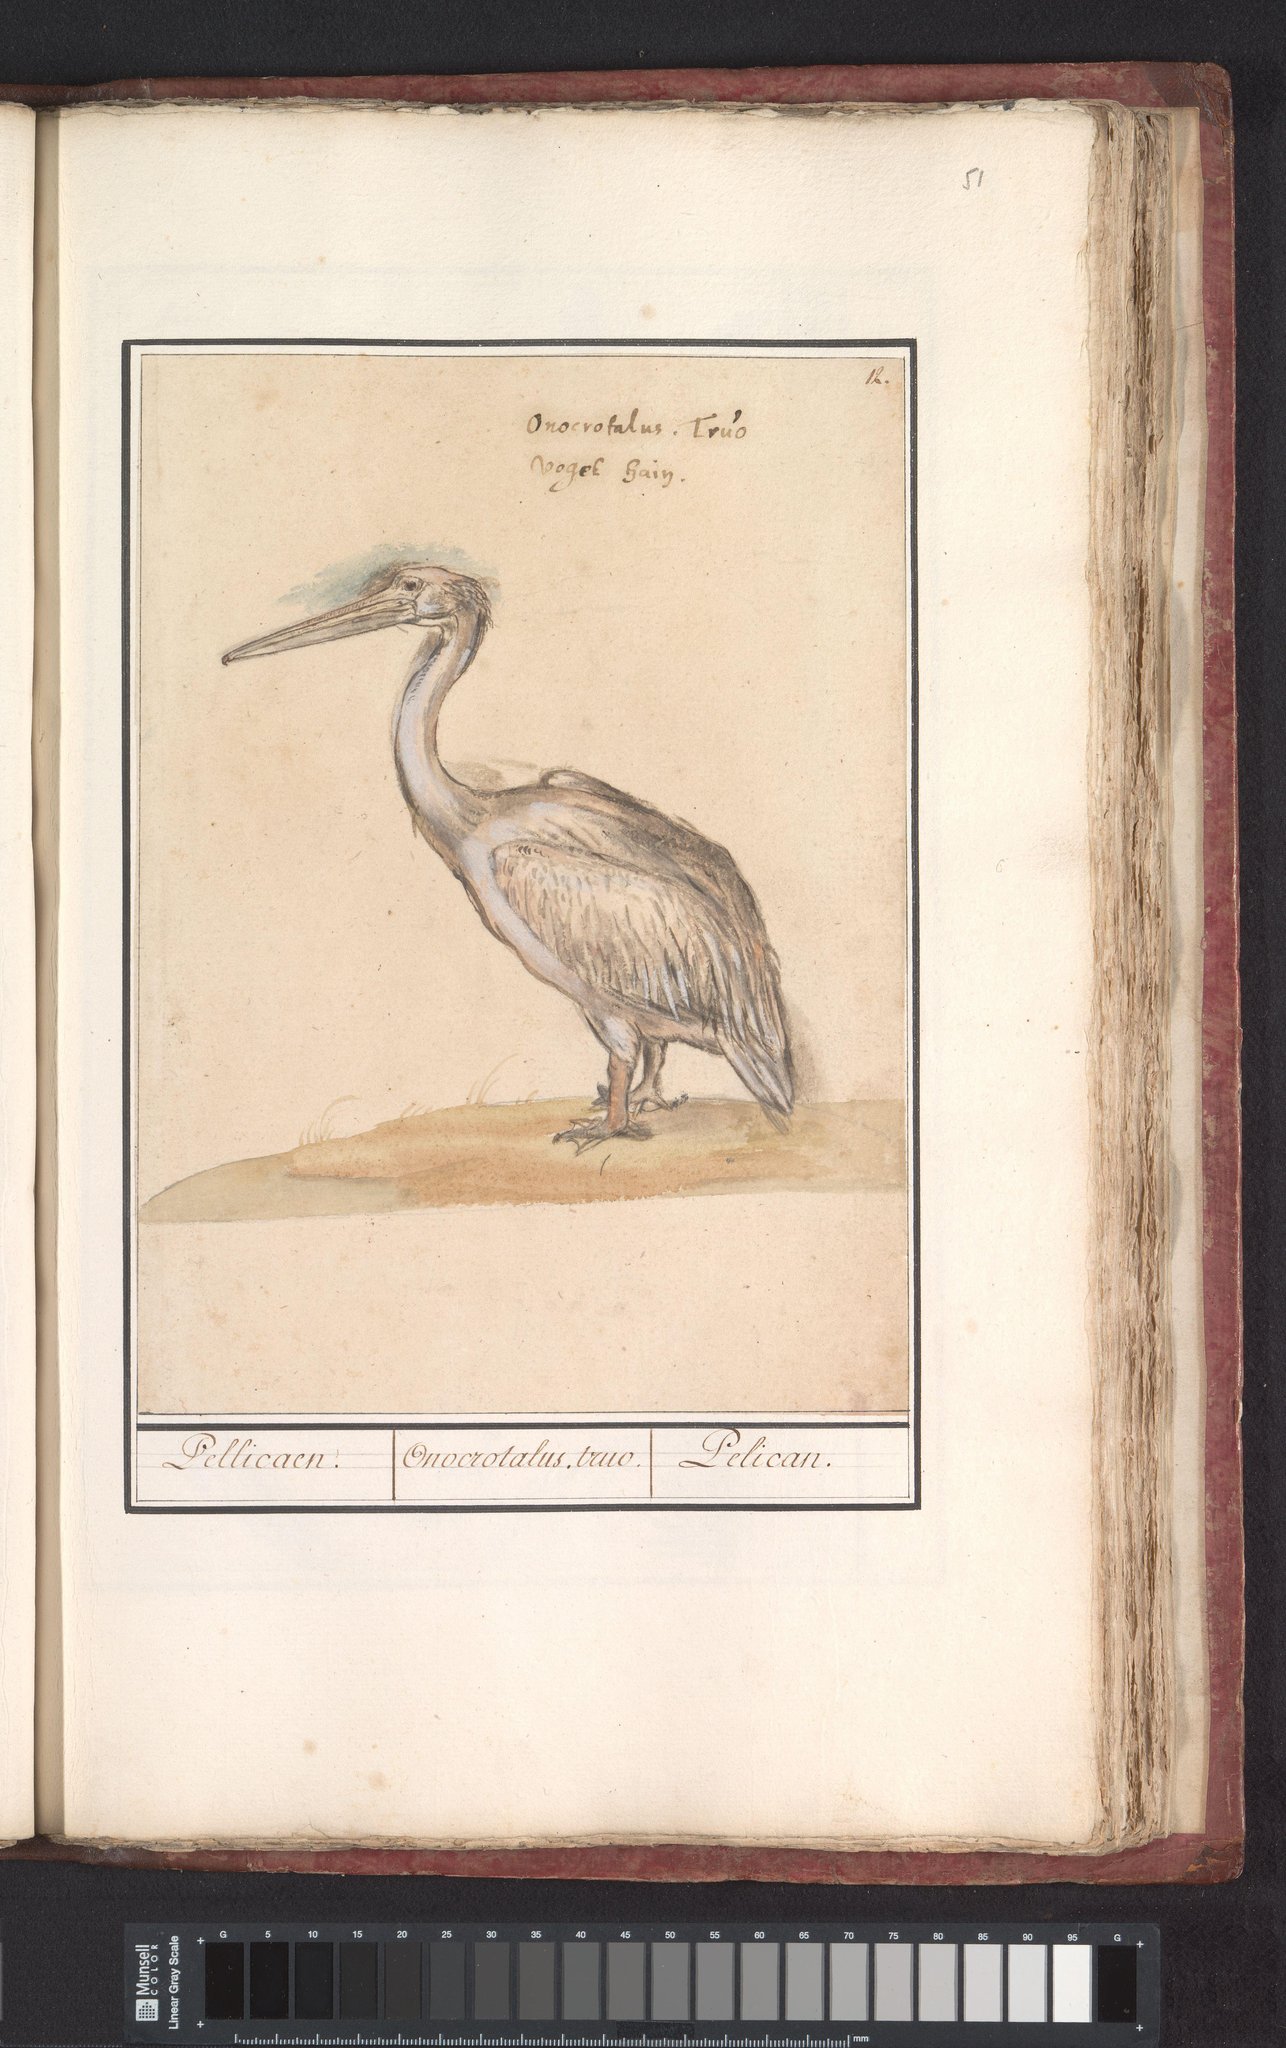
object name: drawing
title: Pellicaen. / Onocrotalus. truo. / Pelican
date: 1596-1610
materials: chalk, paint, ink, paper, pencil, watercolor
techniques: brush, pen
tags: water-birds: pelican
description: Pelikaan. Genummerd rechtsboven: 12. Bovenaan de Latijnse en Duitse naam. Onderdeel van het derde album met tekeningen van vogels. Vijfde van twaalf albums met tekeningen van dieren, vogels en planten bekend rond 1600, gemaakt in opdracht van keizer Rudolf II. Met toelichting in Nederlands, Latijn en Frans.